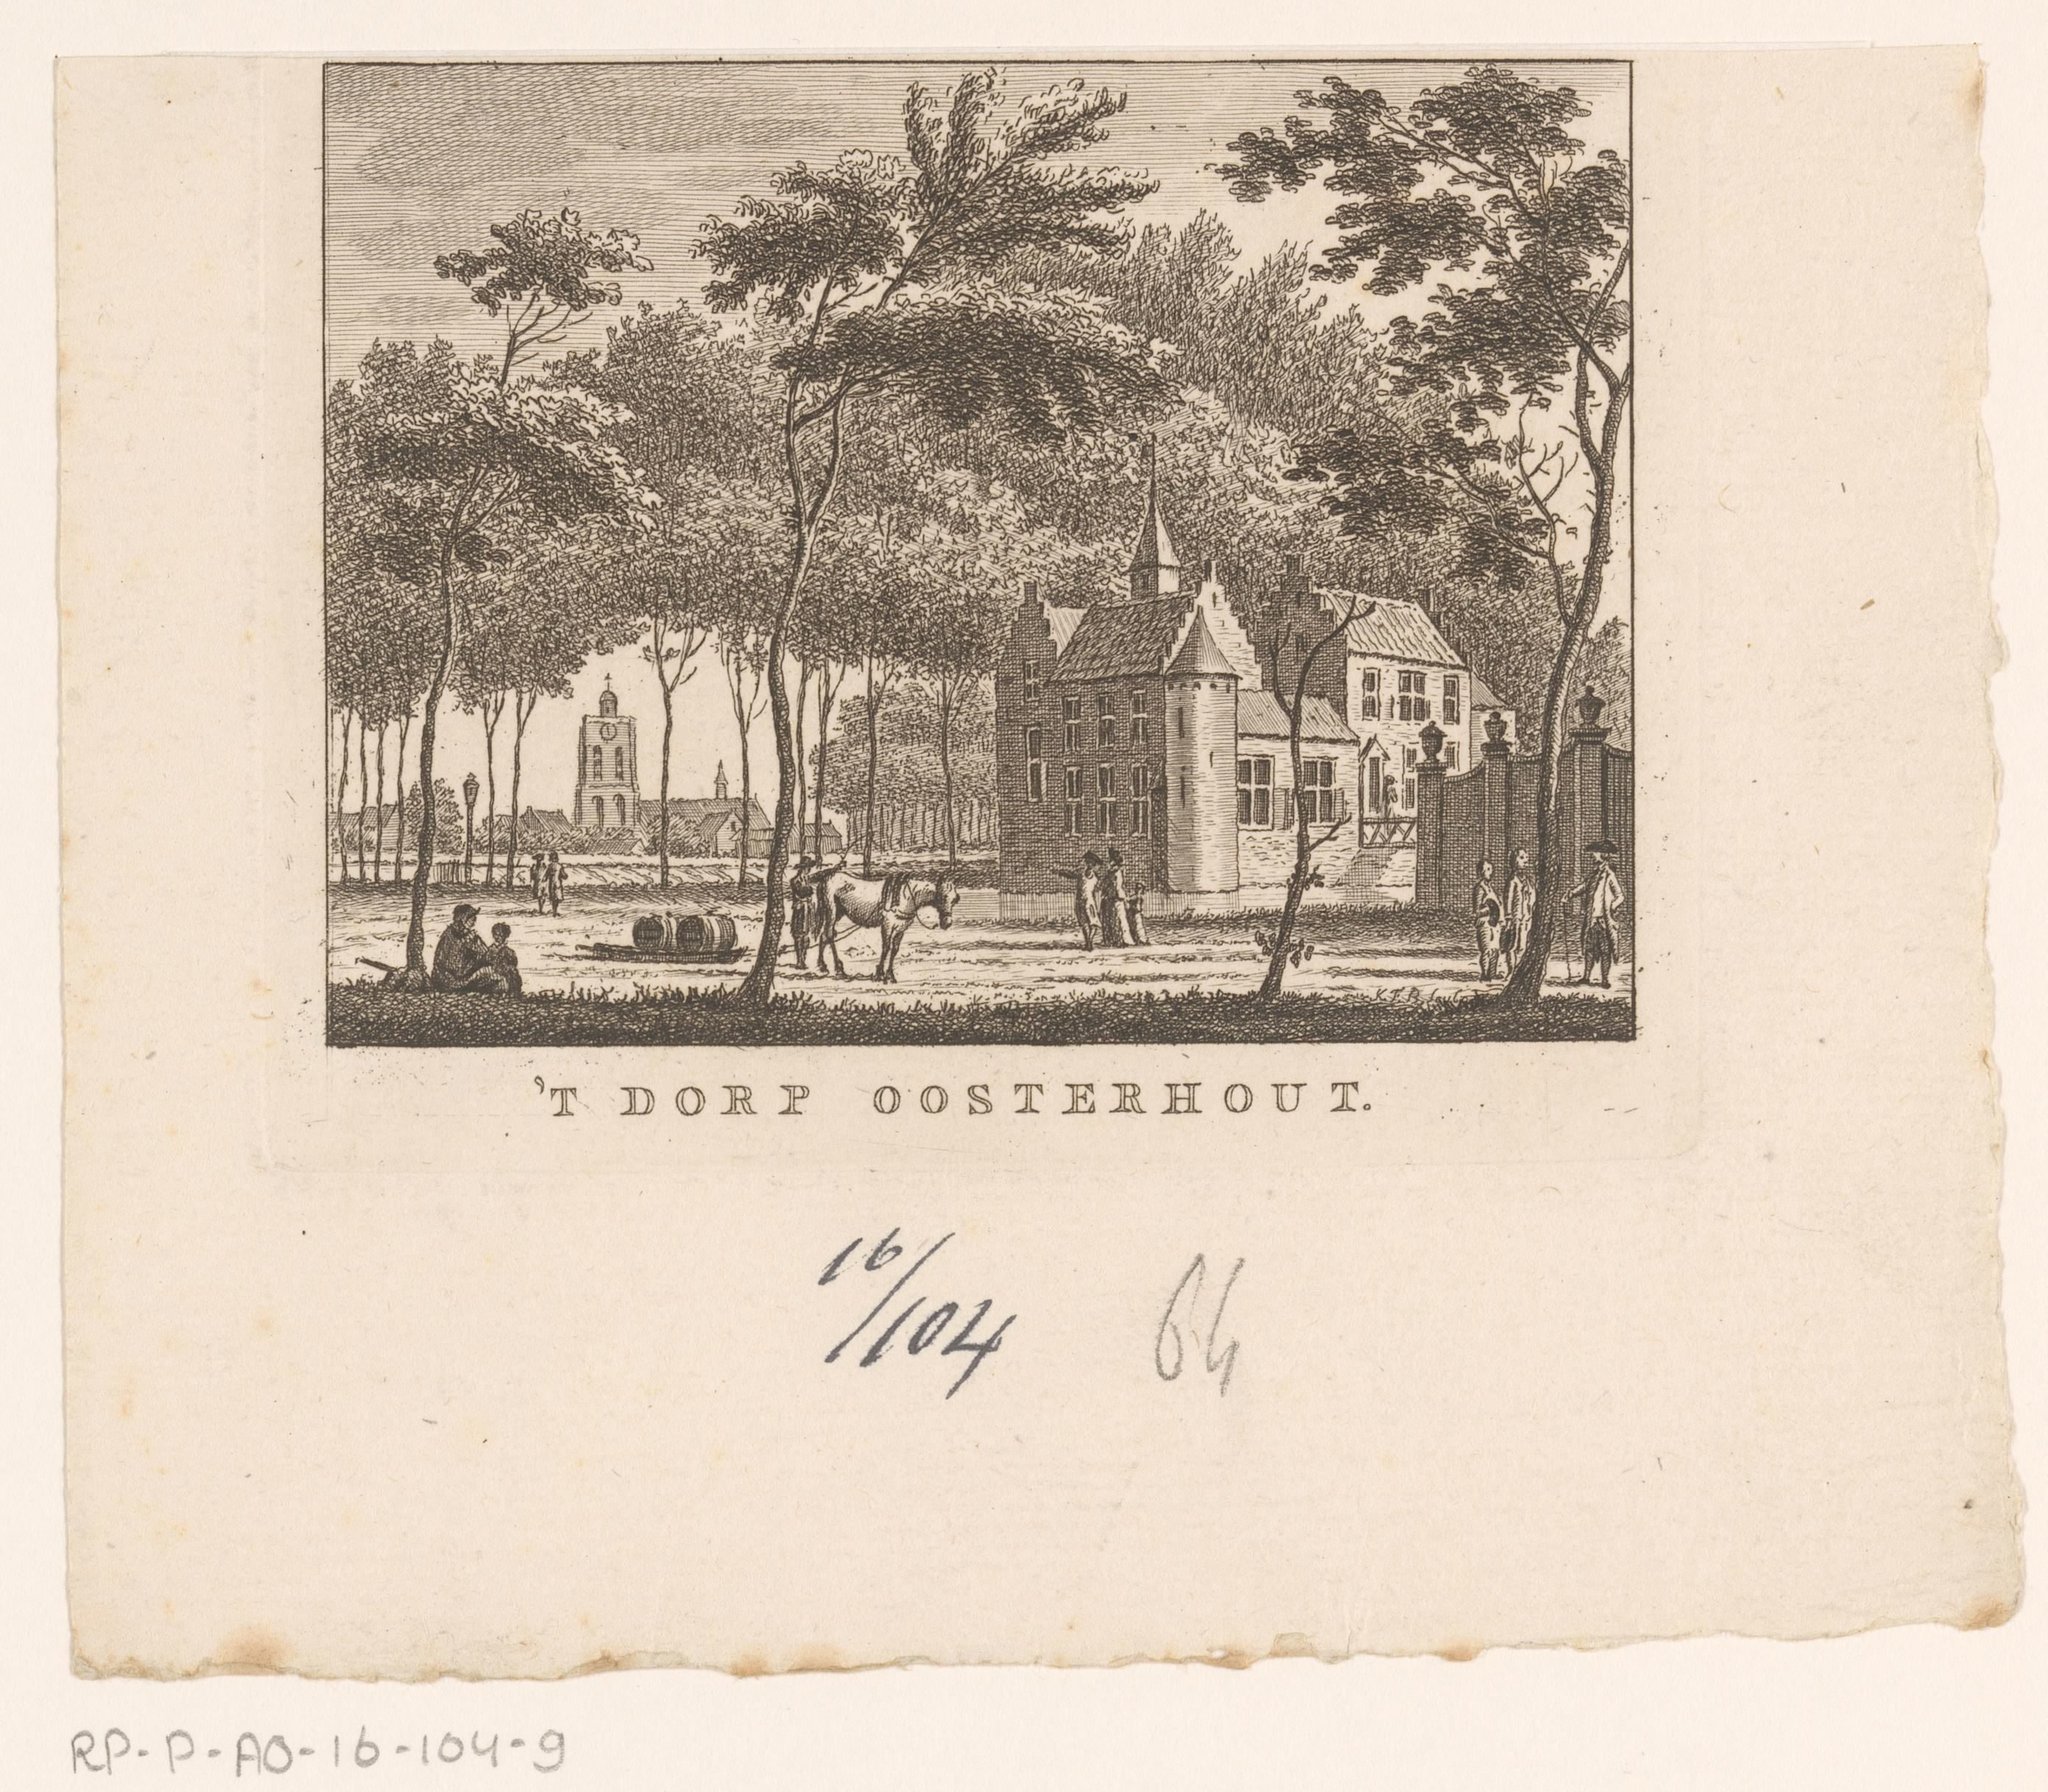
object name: print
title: Gezicht op Oosterhout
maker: carel frederik bendorp (i)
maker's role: print maker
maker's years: 1736-1814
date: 1786-1792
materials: paper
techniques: engraving, etching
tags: prospect of village, silhouette of village, church (exterior)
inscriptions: collector's mark: Lugt 2228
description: Prent uit: Vaderlandsche gezichten, of afbeeldingen van den tegenwoordigen staat der Vereenigde Nederlanden (…). Amsterdam: Hendrik Gartman, Willem Vermandel en Jan Willem Smit, 1786-1792. Uitgegeven in afleveringen met ieder een eigen bifolium en inhoudsopgave. Alle prenten in deze publicatie zijn gegraveerd door Carel Frederik Bendorp (I) en, in de meeste gevallen, gebaseerd op tekeningen van Jan Bulthuis.